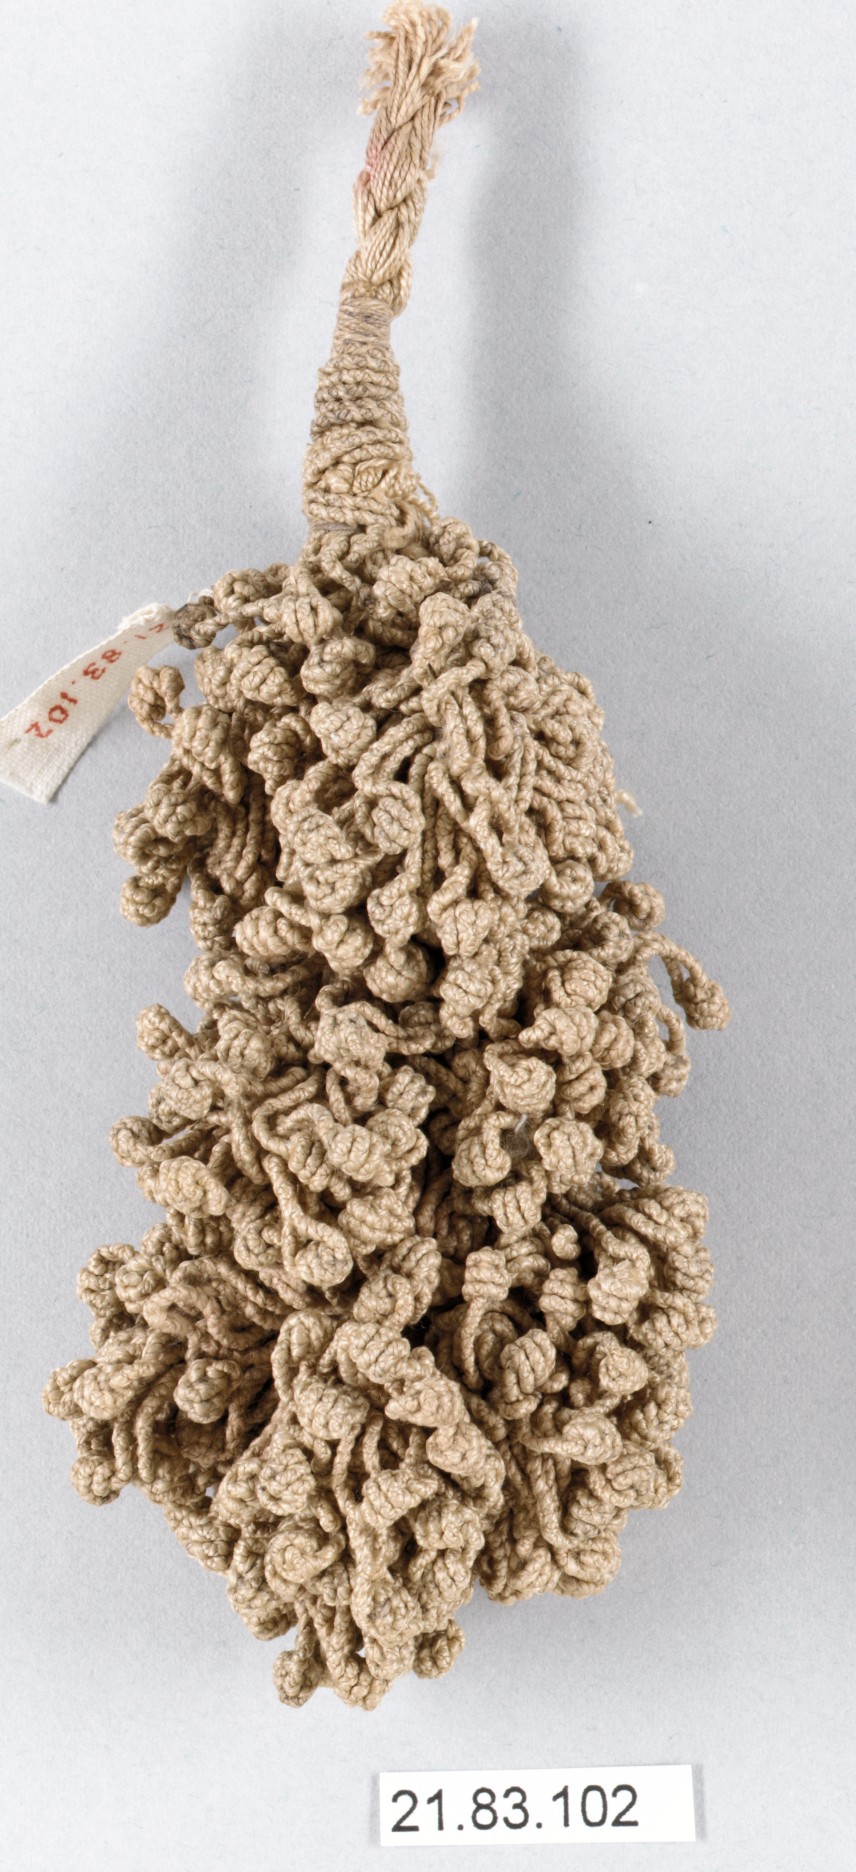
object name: tassel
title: Pair of tassels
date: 1601-1700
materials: linen